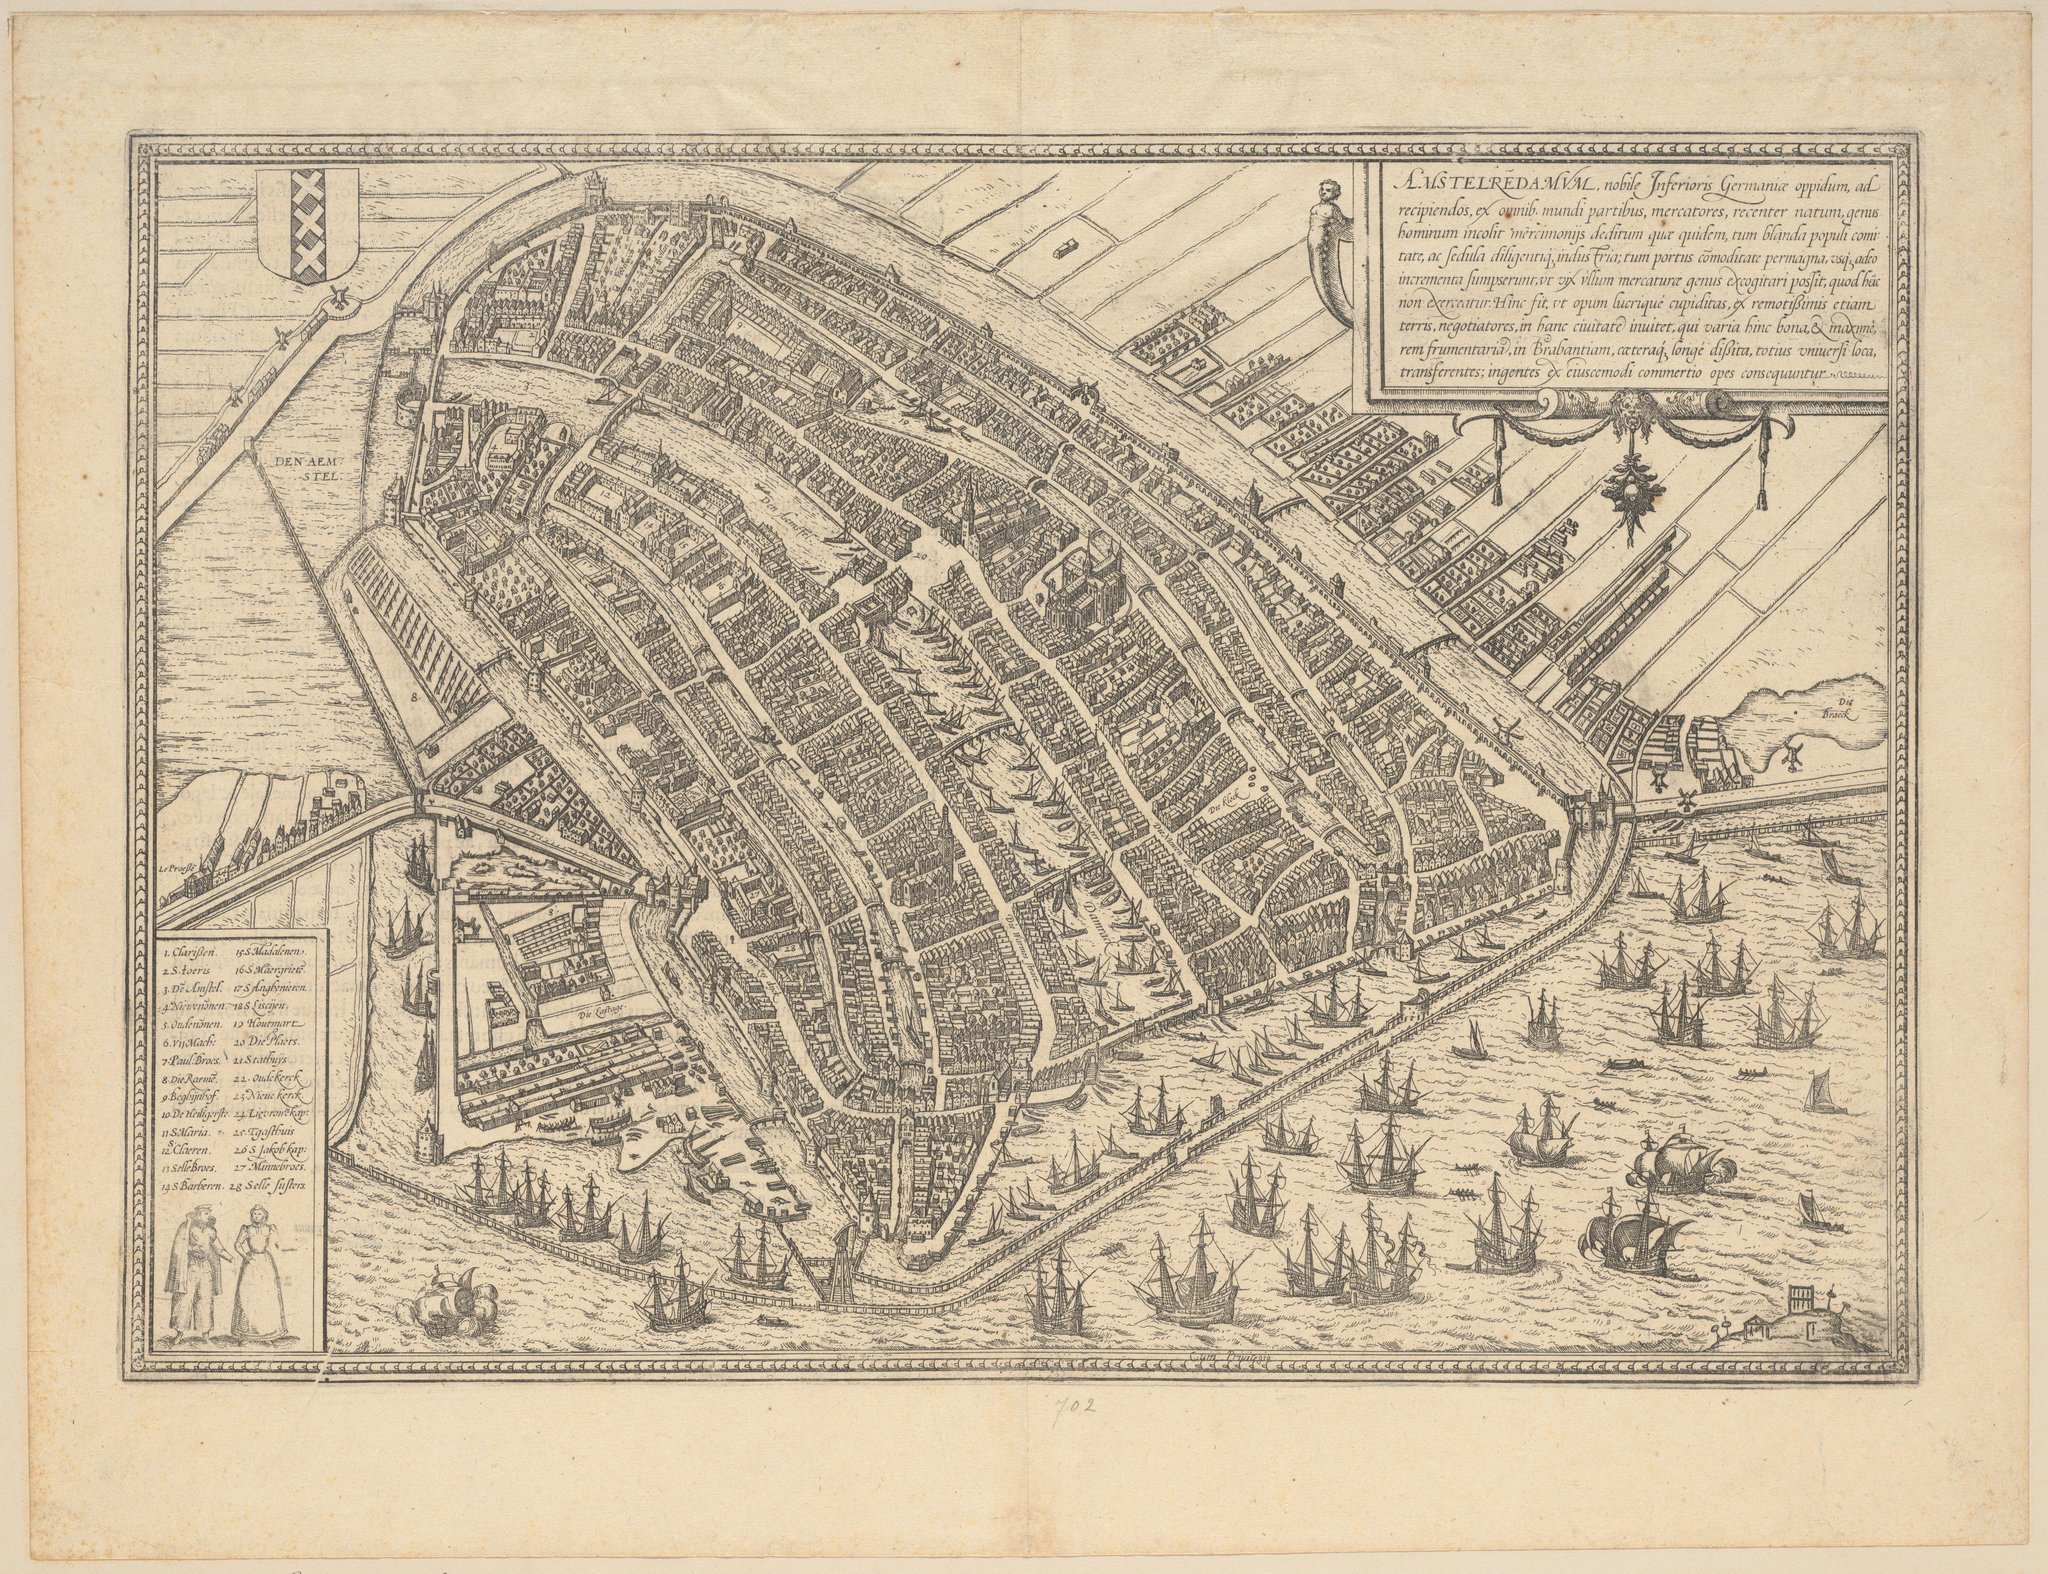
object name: print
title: Amstelredamum, nobile Inferioris Germaniae oppidum, ad recipiendos, ex omnib. mondi partibus, mercatores, recenter natum (…)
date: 1618-1657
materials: paper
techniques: engraving, etching, letterpress printing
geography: cologne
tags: coat of arms (as symbol of the state, etc.) (+ city; municipal), folk costume, regional costume, maps of cities, amsterdam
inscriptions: collector's mark: Lugt 1641b